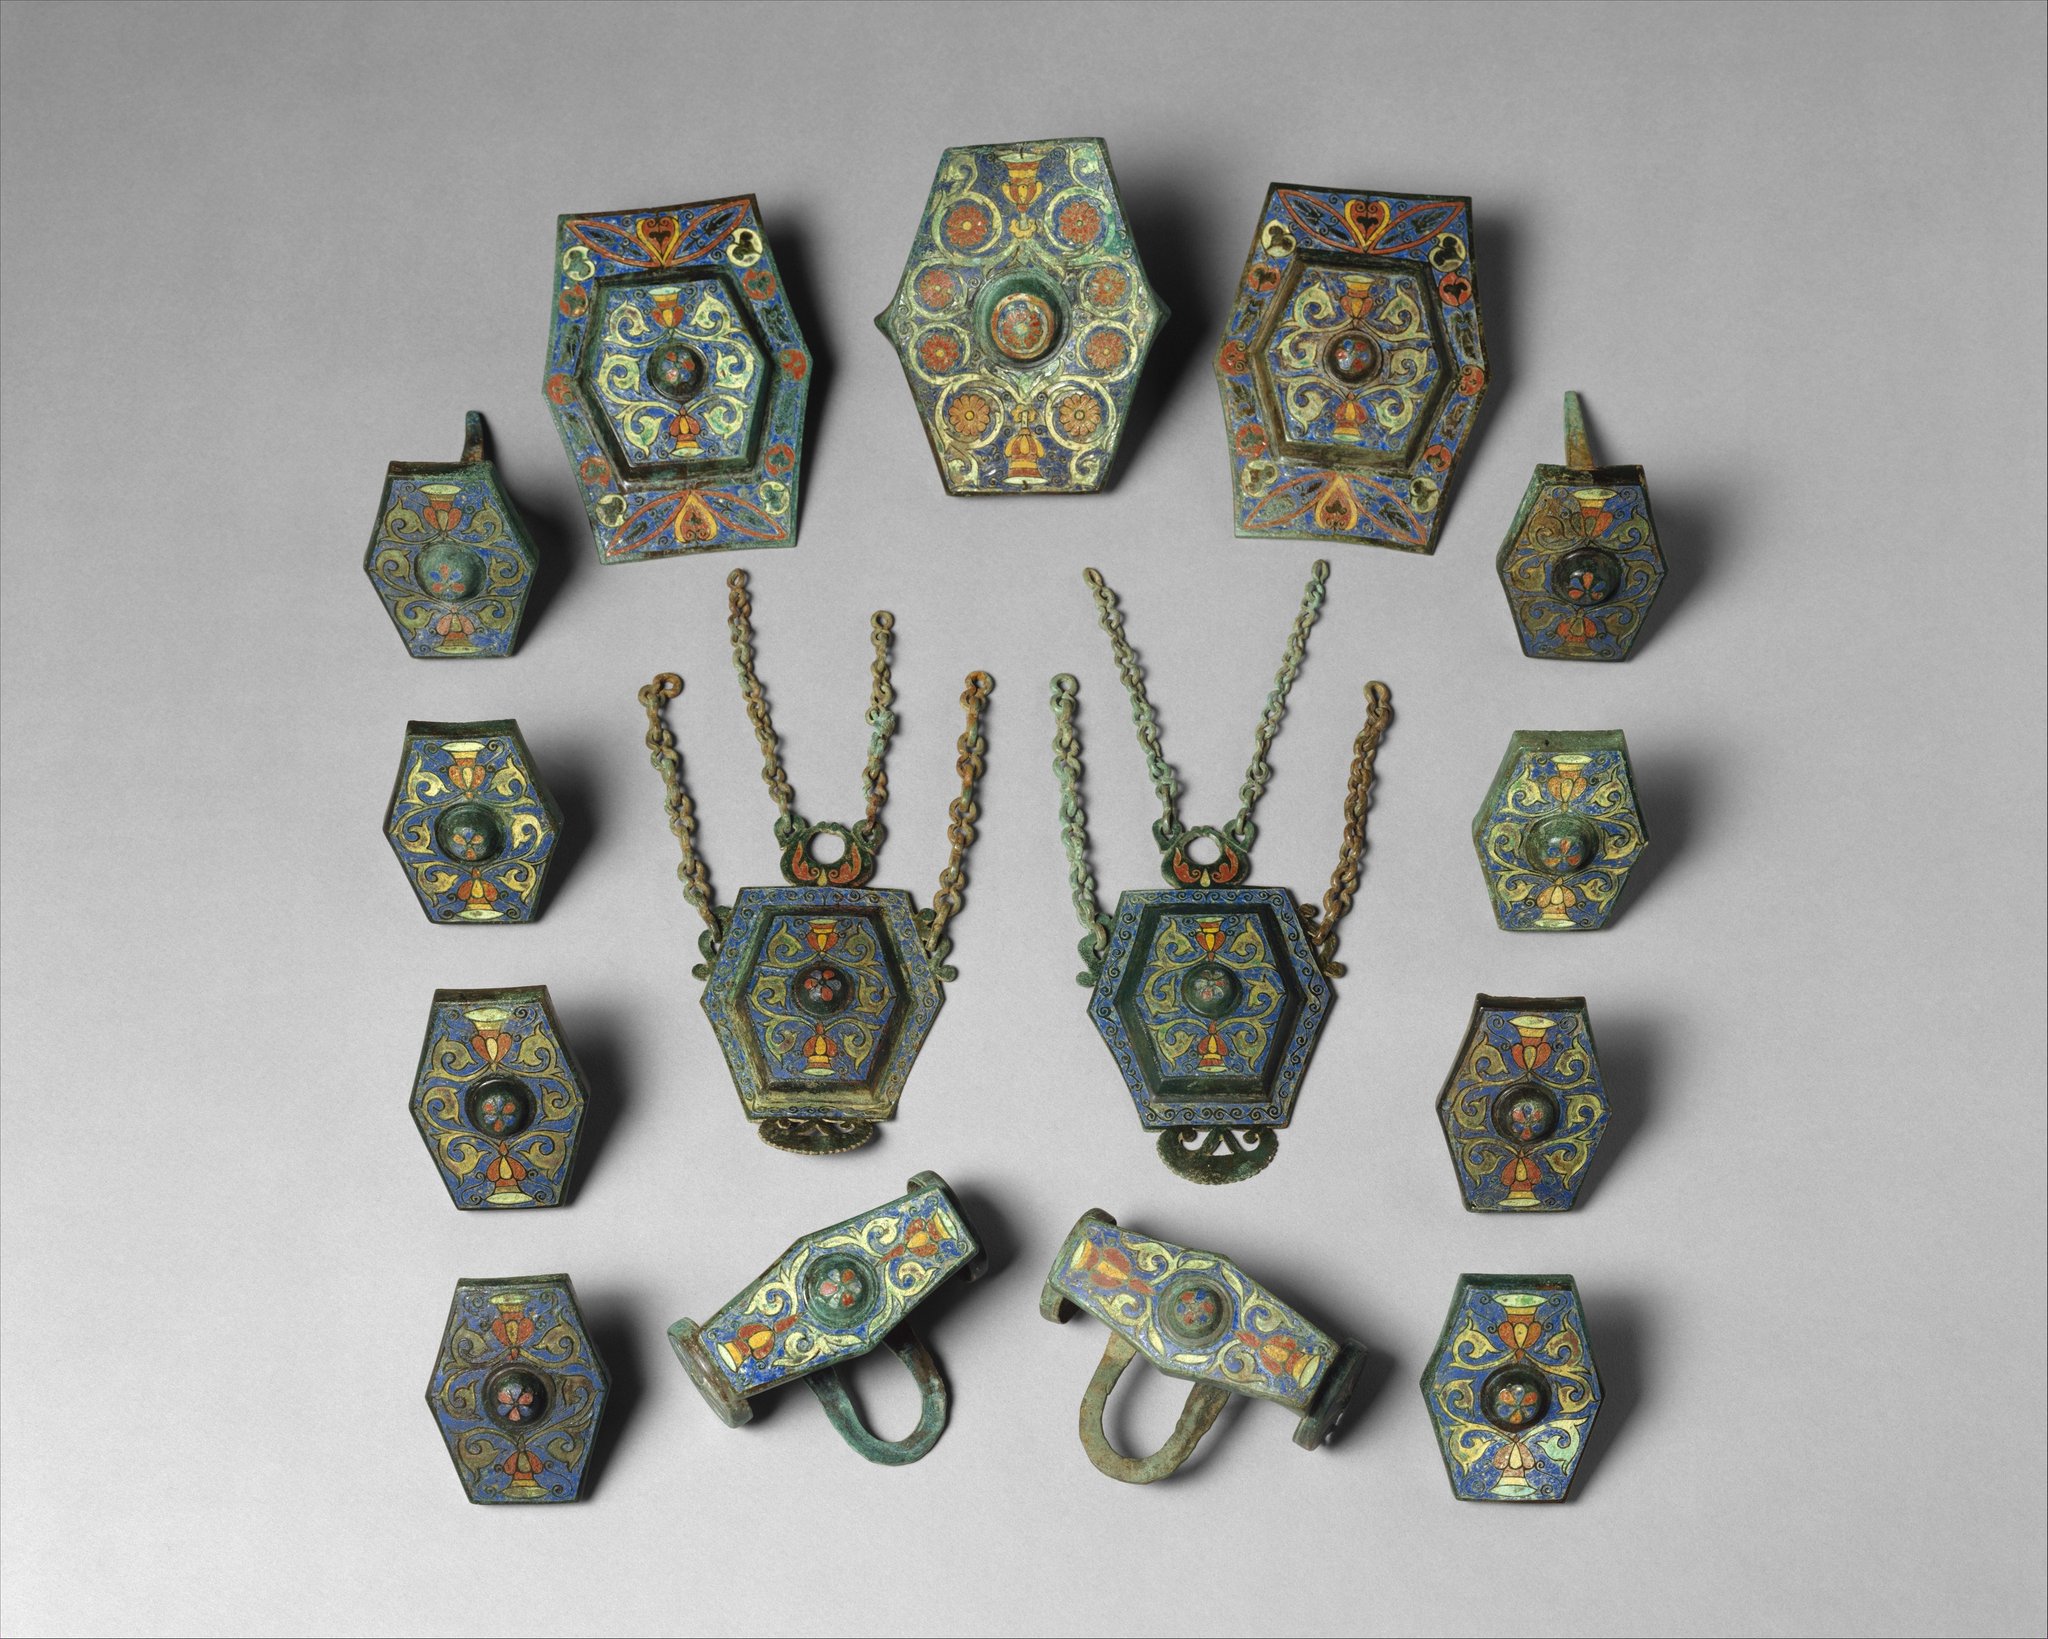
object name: harness ornament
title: Harness Ornaments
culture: late roman or byzantine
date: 200-400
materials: copper alloy, enamel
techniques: enamel